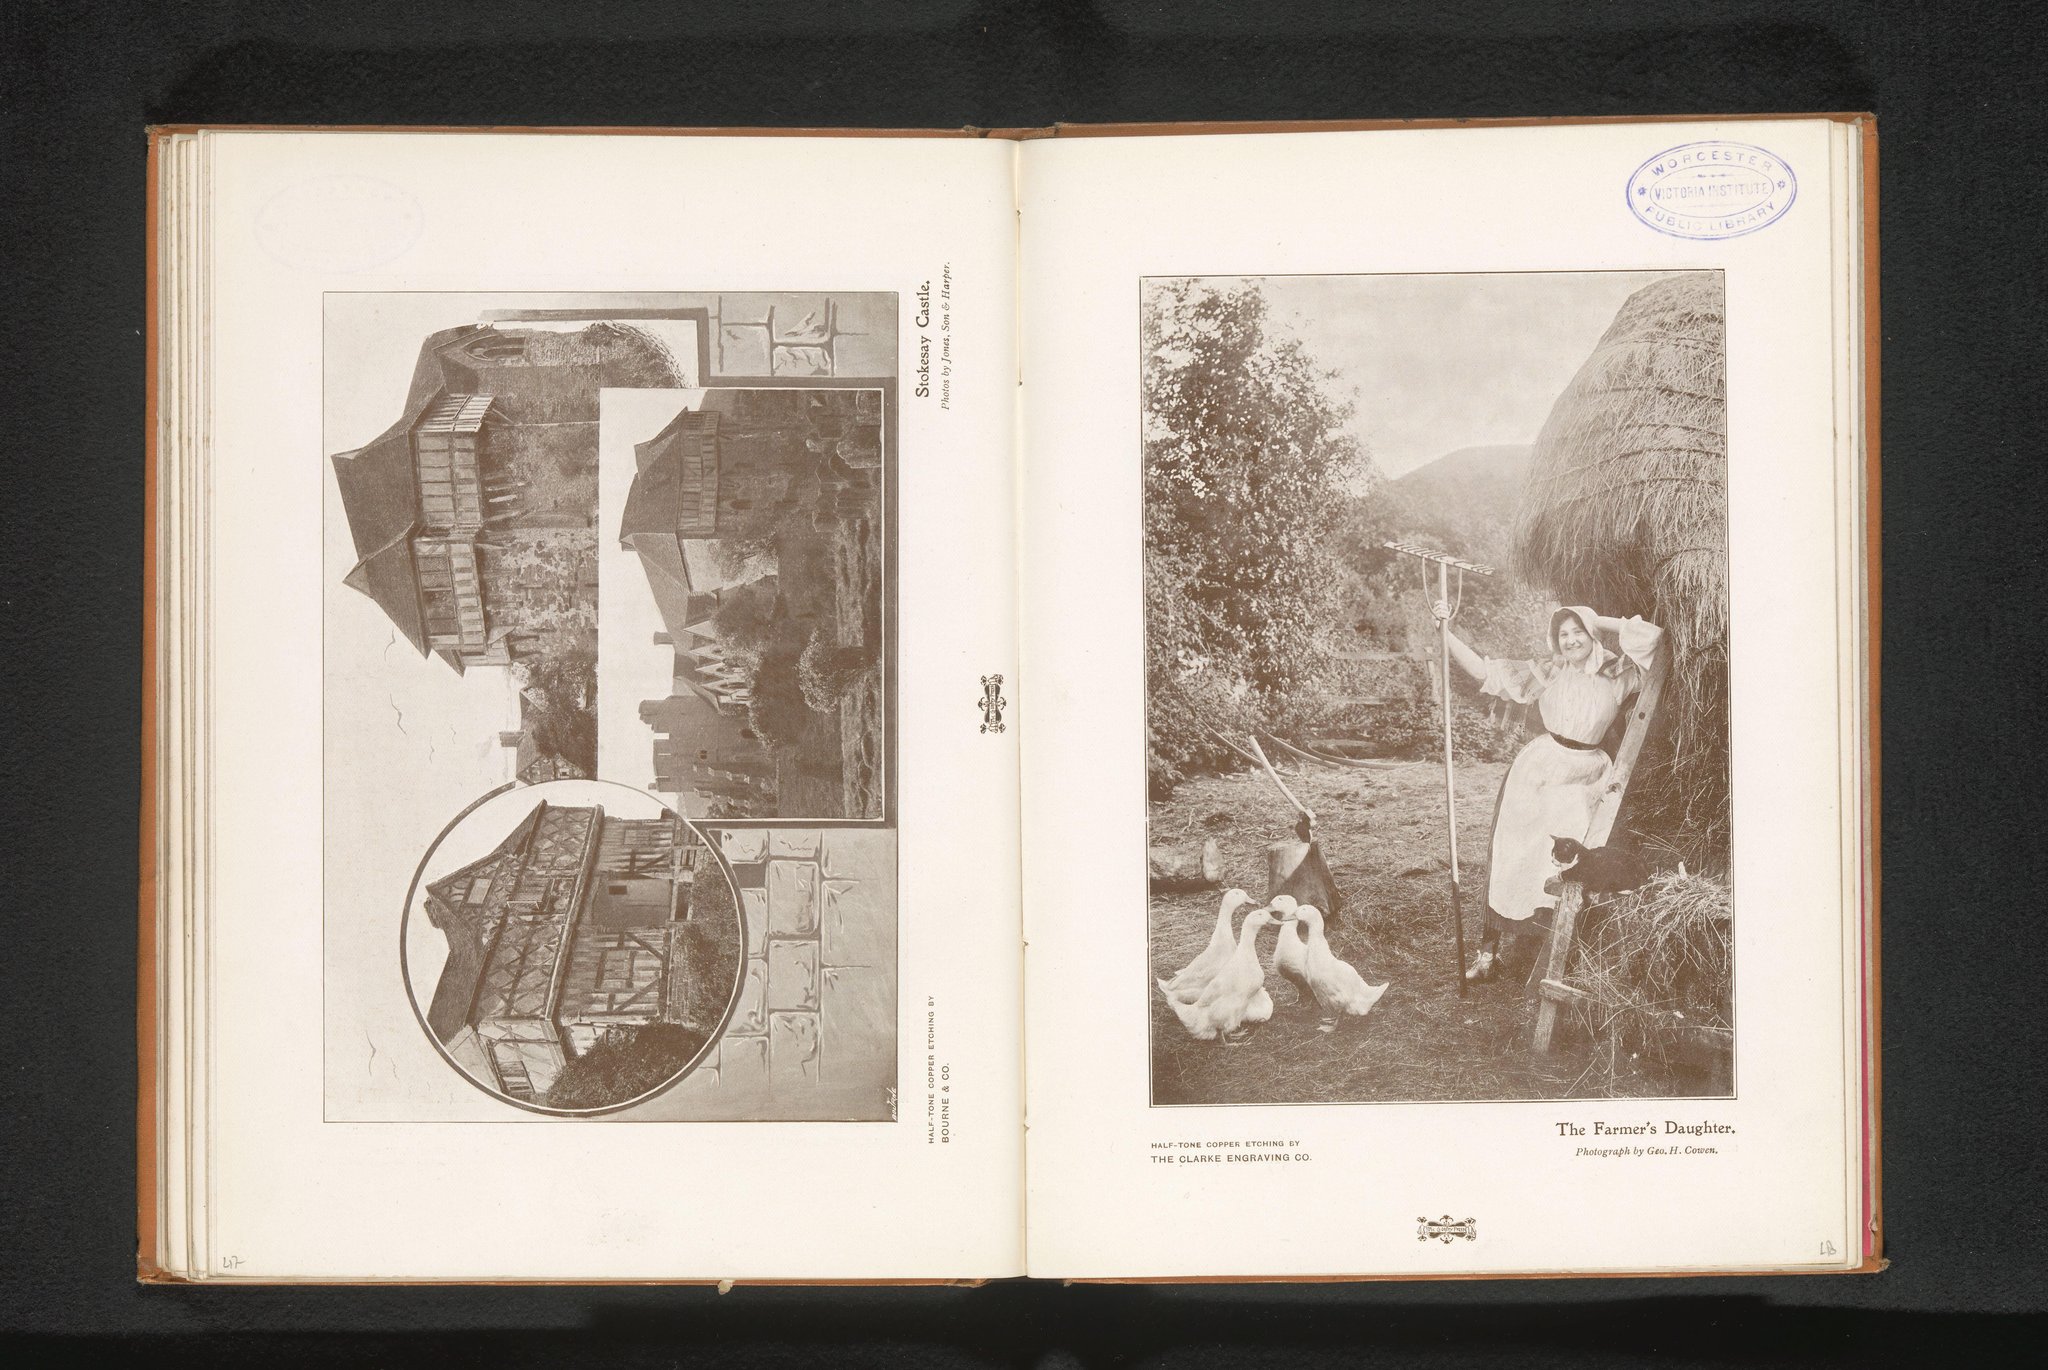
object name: page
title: Stokesay Castle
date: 1894-1899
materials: paper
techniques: autotype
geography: stokesay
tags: castle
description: Prent op tweede ongenummerde pagina na pagina 64.